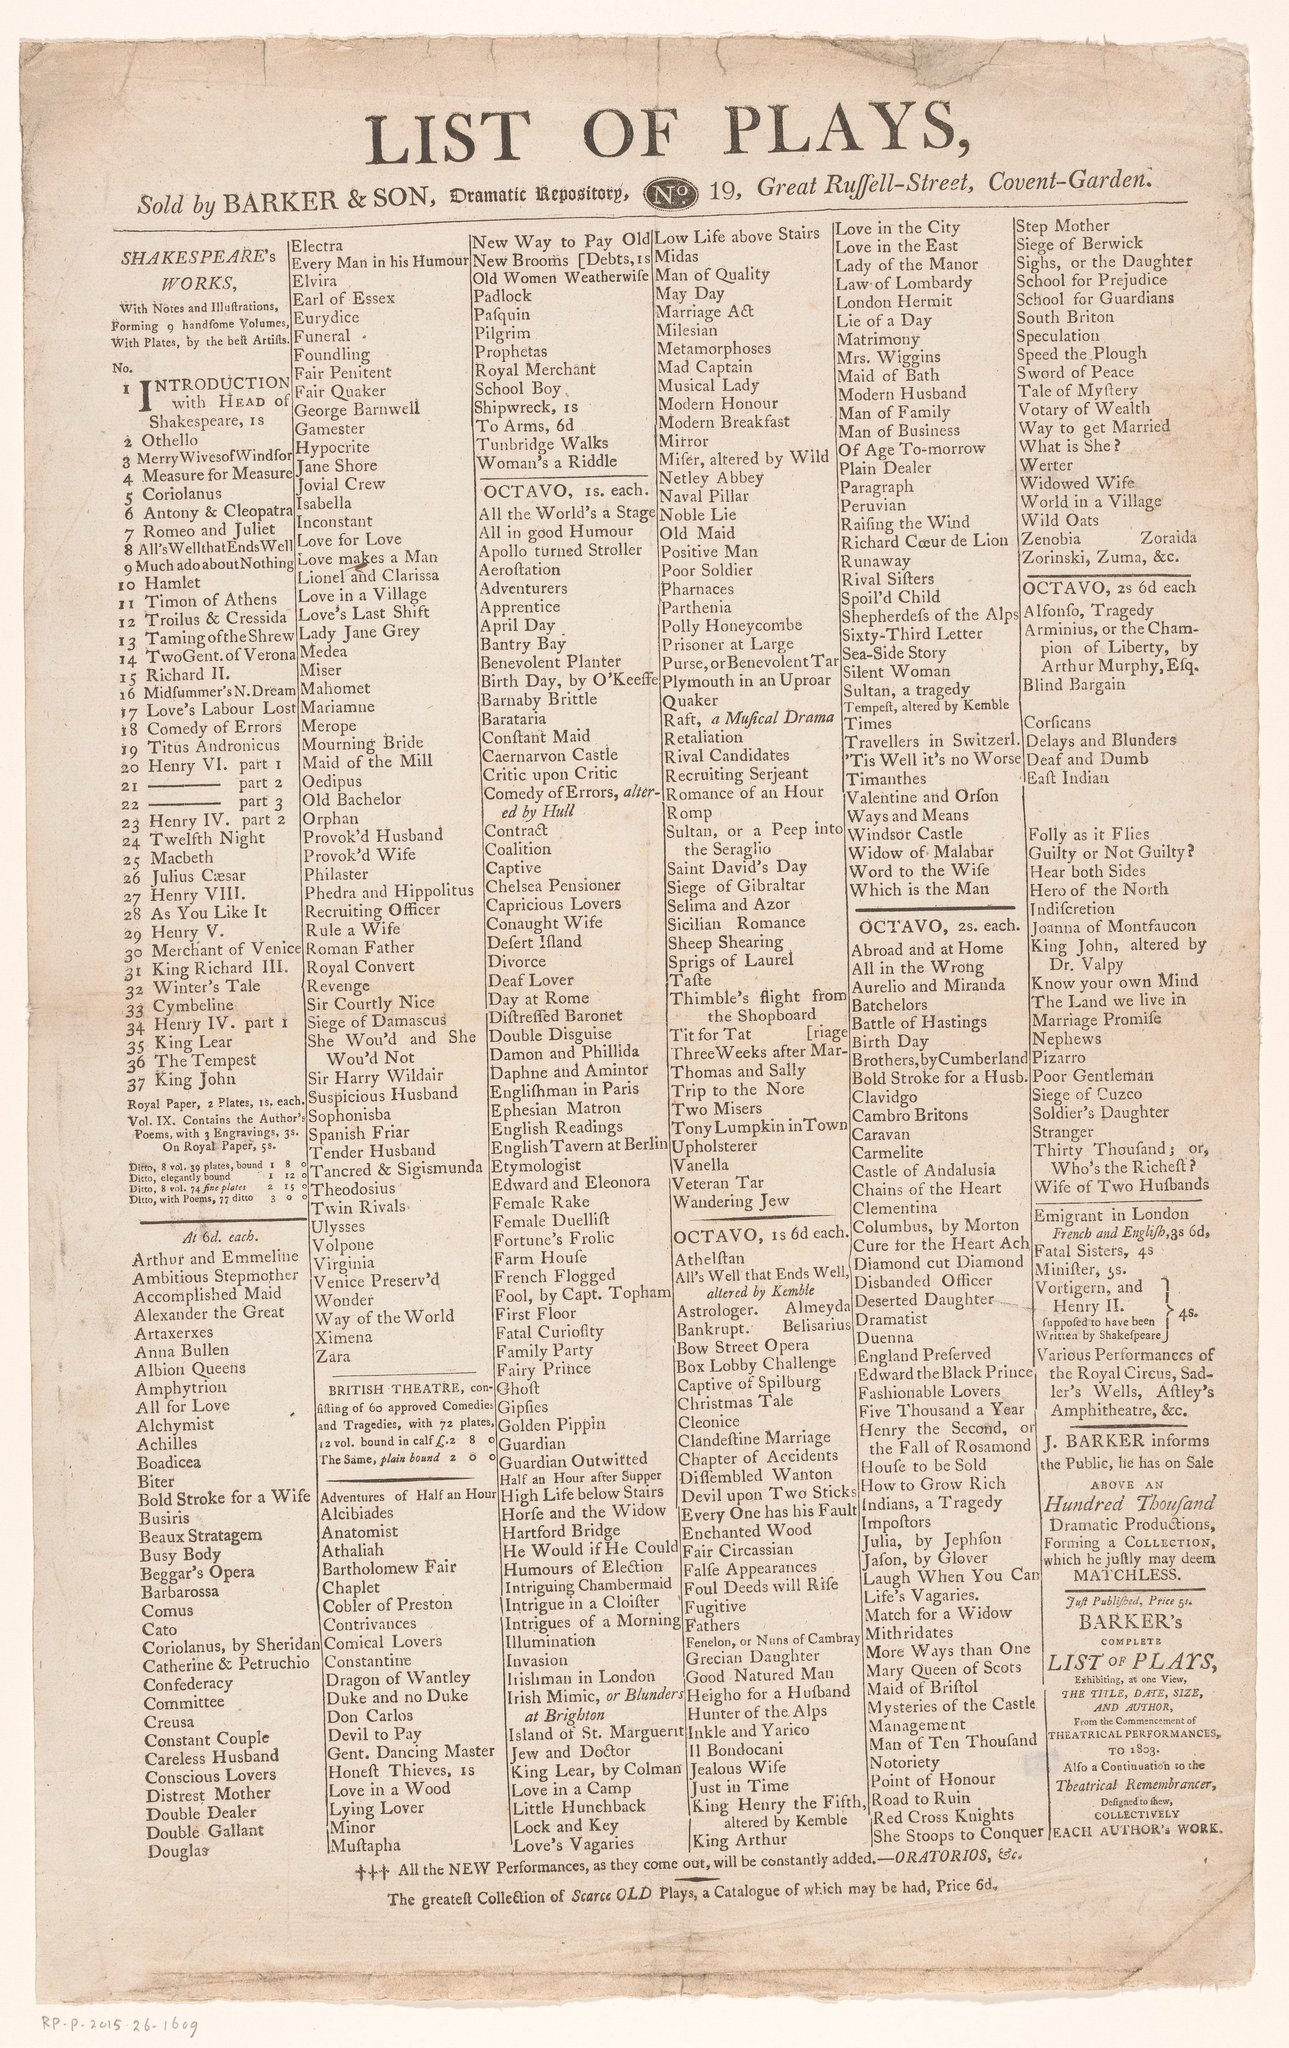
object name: print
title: Fondslijst met toneelstukken te koop bij Barker & Son te Londen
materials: paper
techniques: letterpress printing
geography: london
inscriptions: collector's mark: Lugt 4780, collector's mark: Lugt 2228